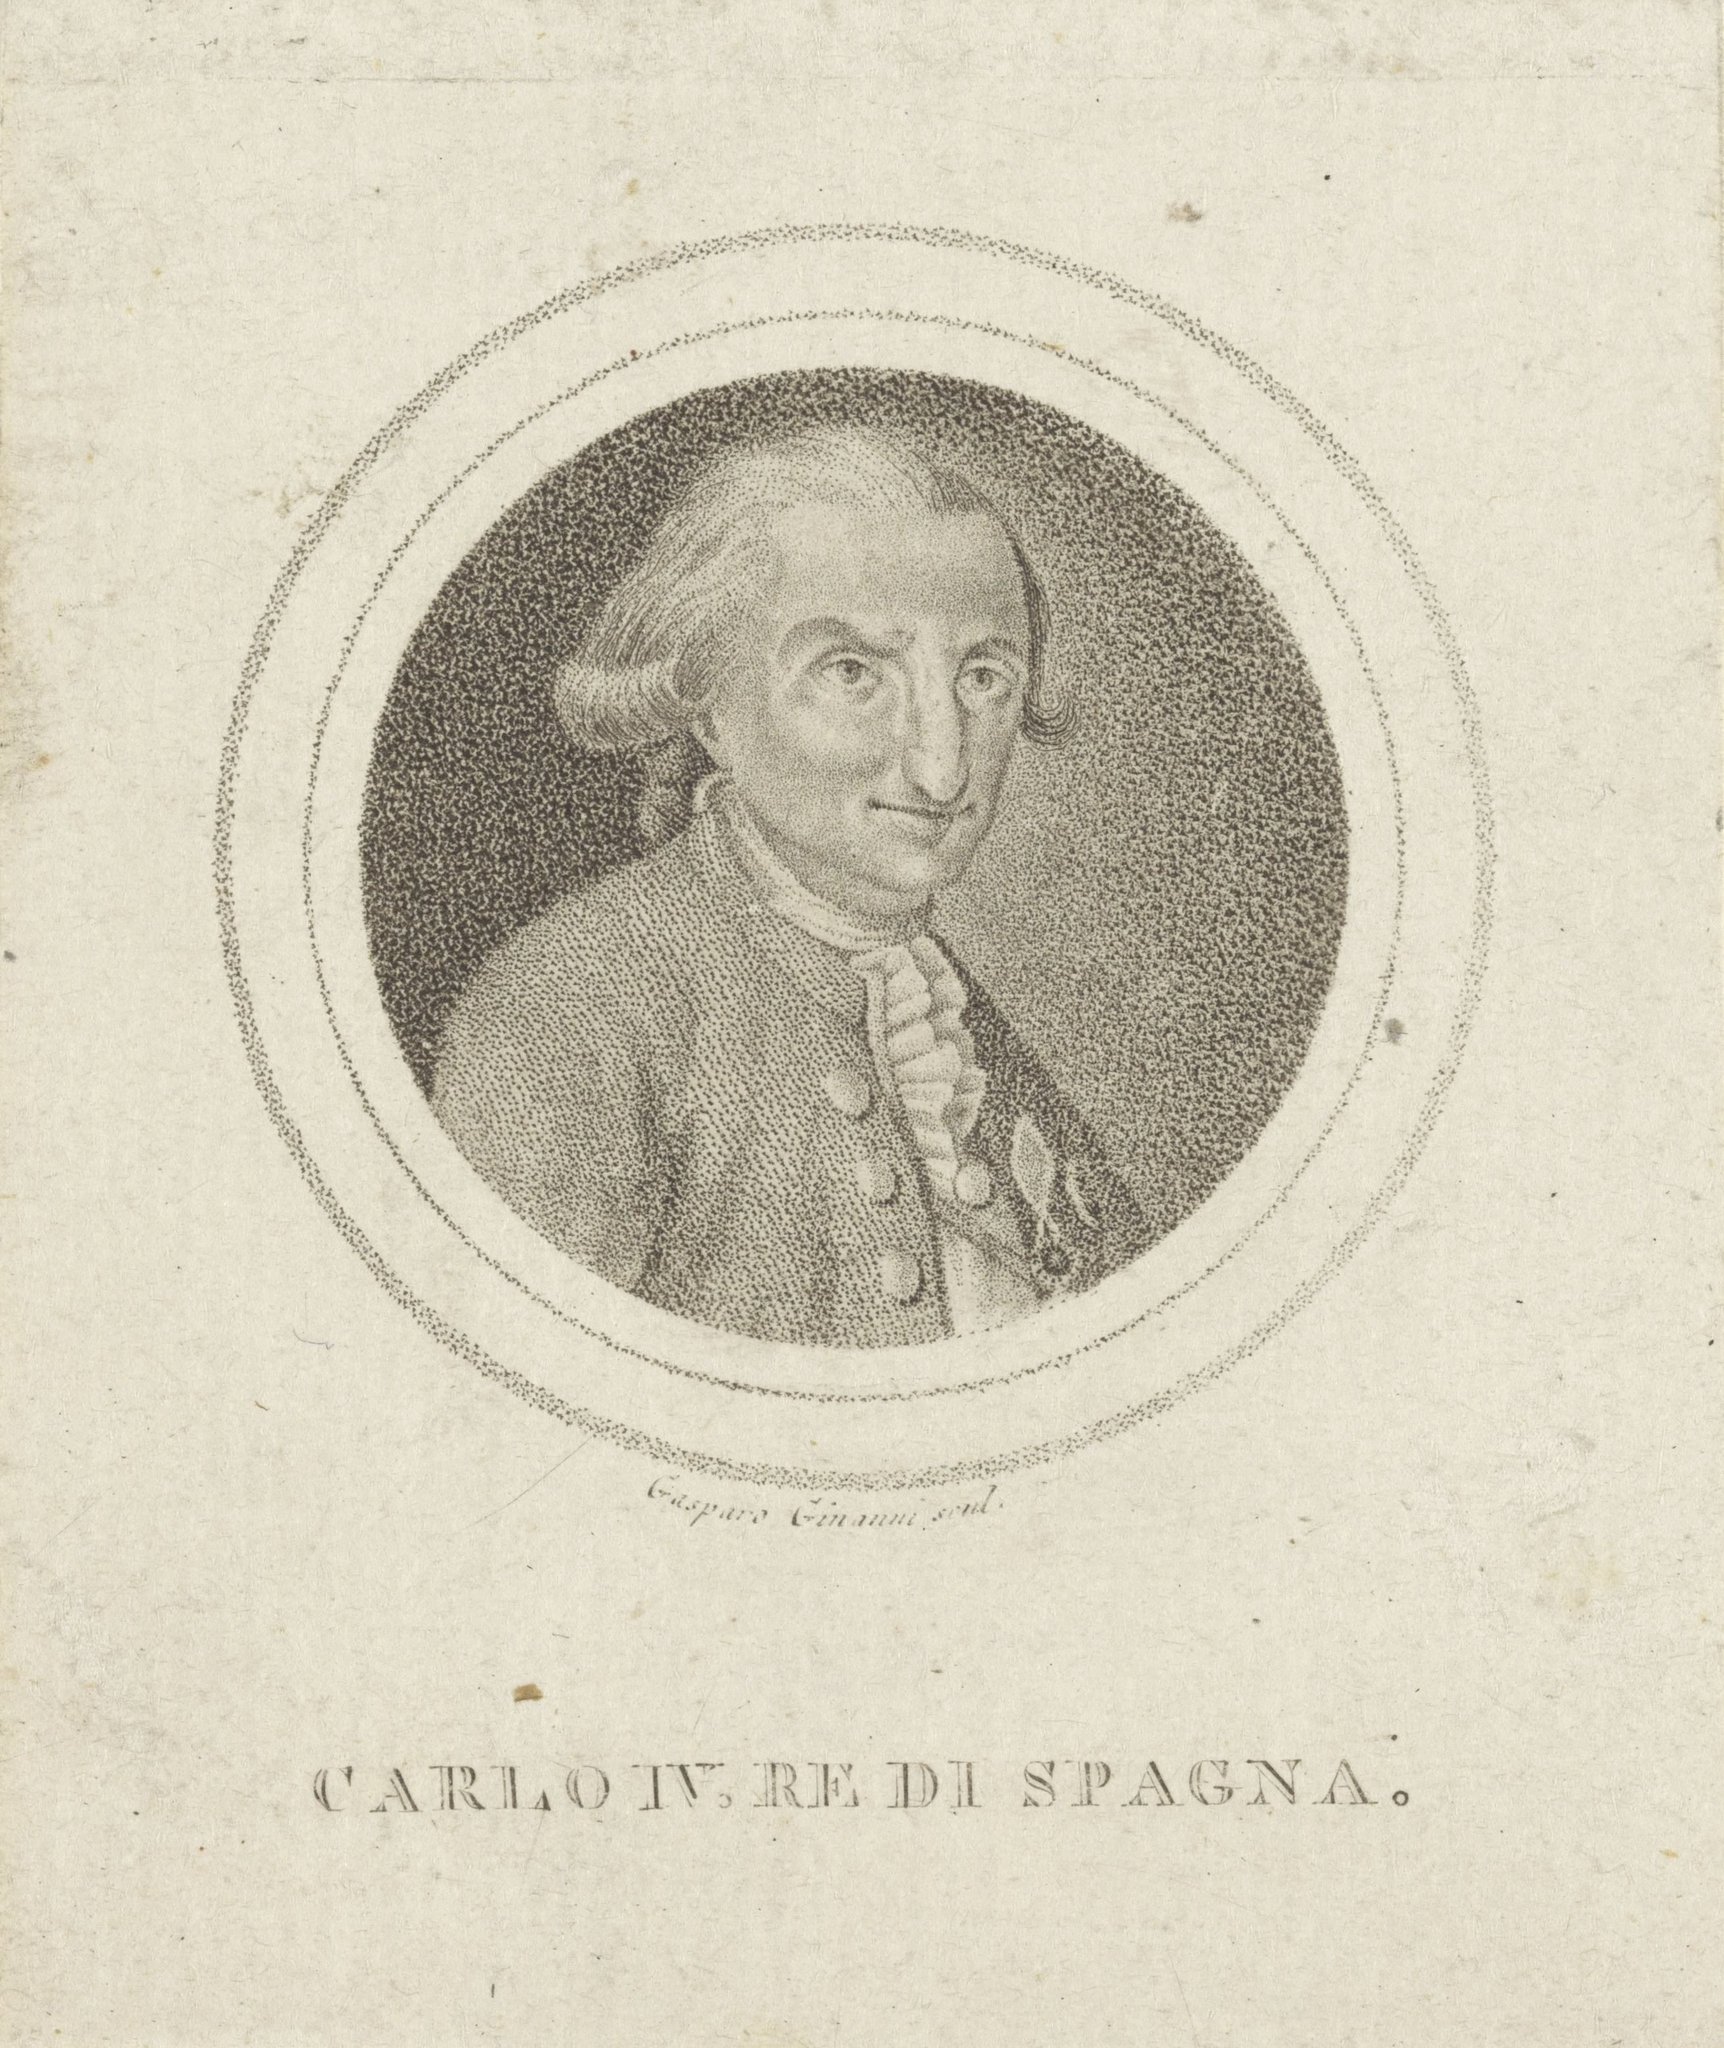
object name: print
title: Portret van Karel IV, koning van Spanje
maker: gaspare ginanni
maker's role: print maker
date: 1791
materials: paper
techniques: stippling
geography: italy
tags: karel iv (koning van spanje), historical persons, ruler, sovereign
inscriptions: collector's mark: Lugt 2228